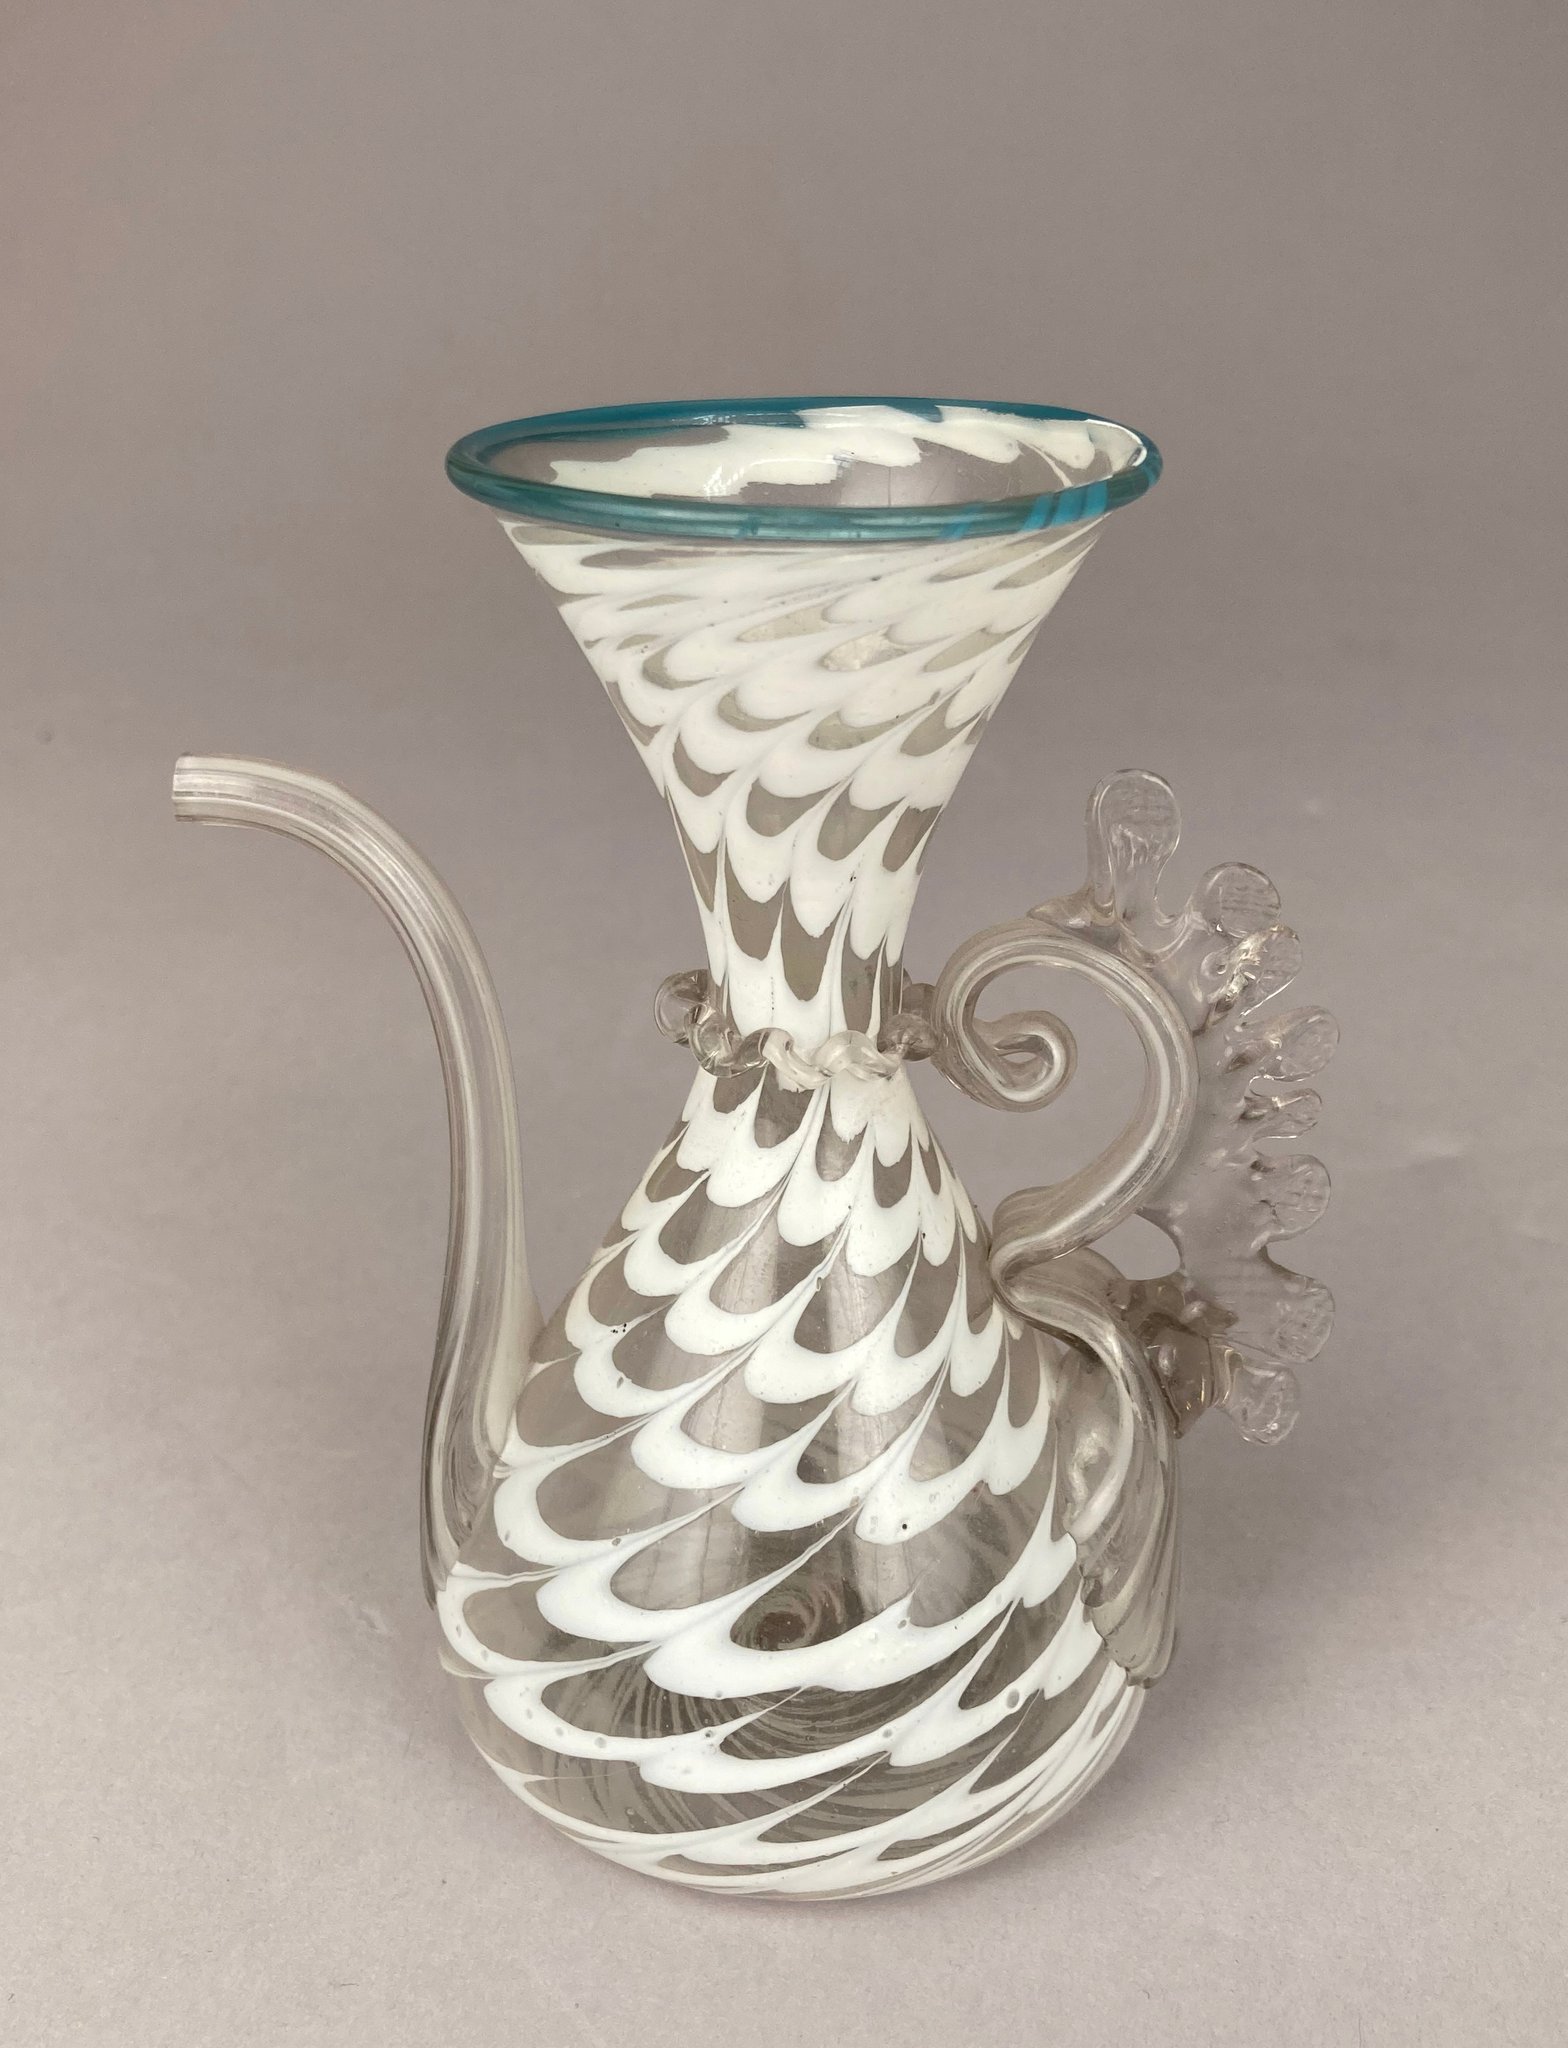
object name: ewer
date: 1601-1650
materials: glass